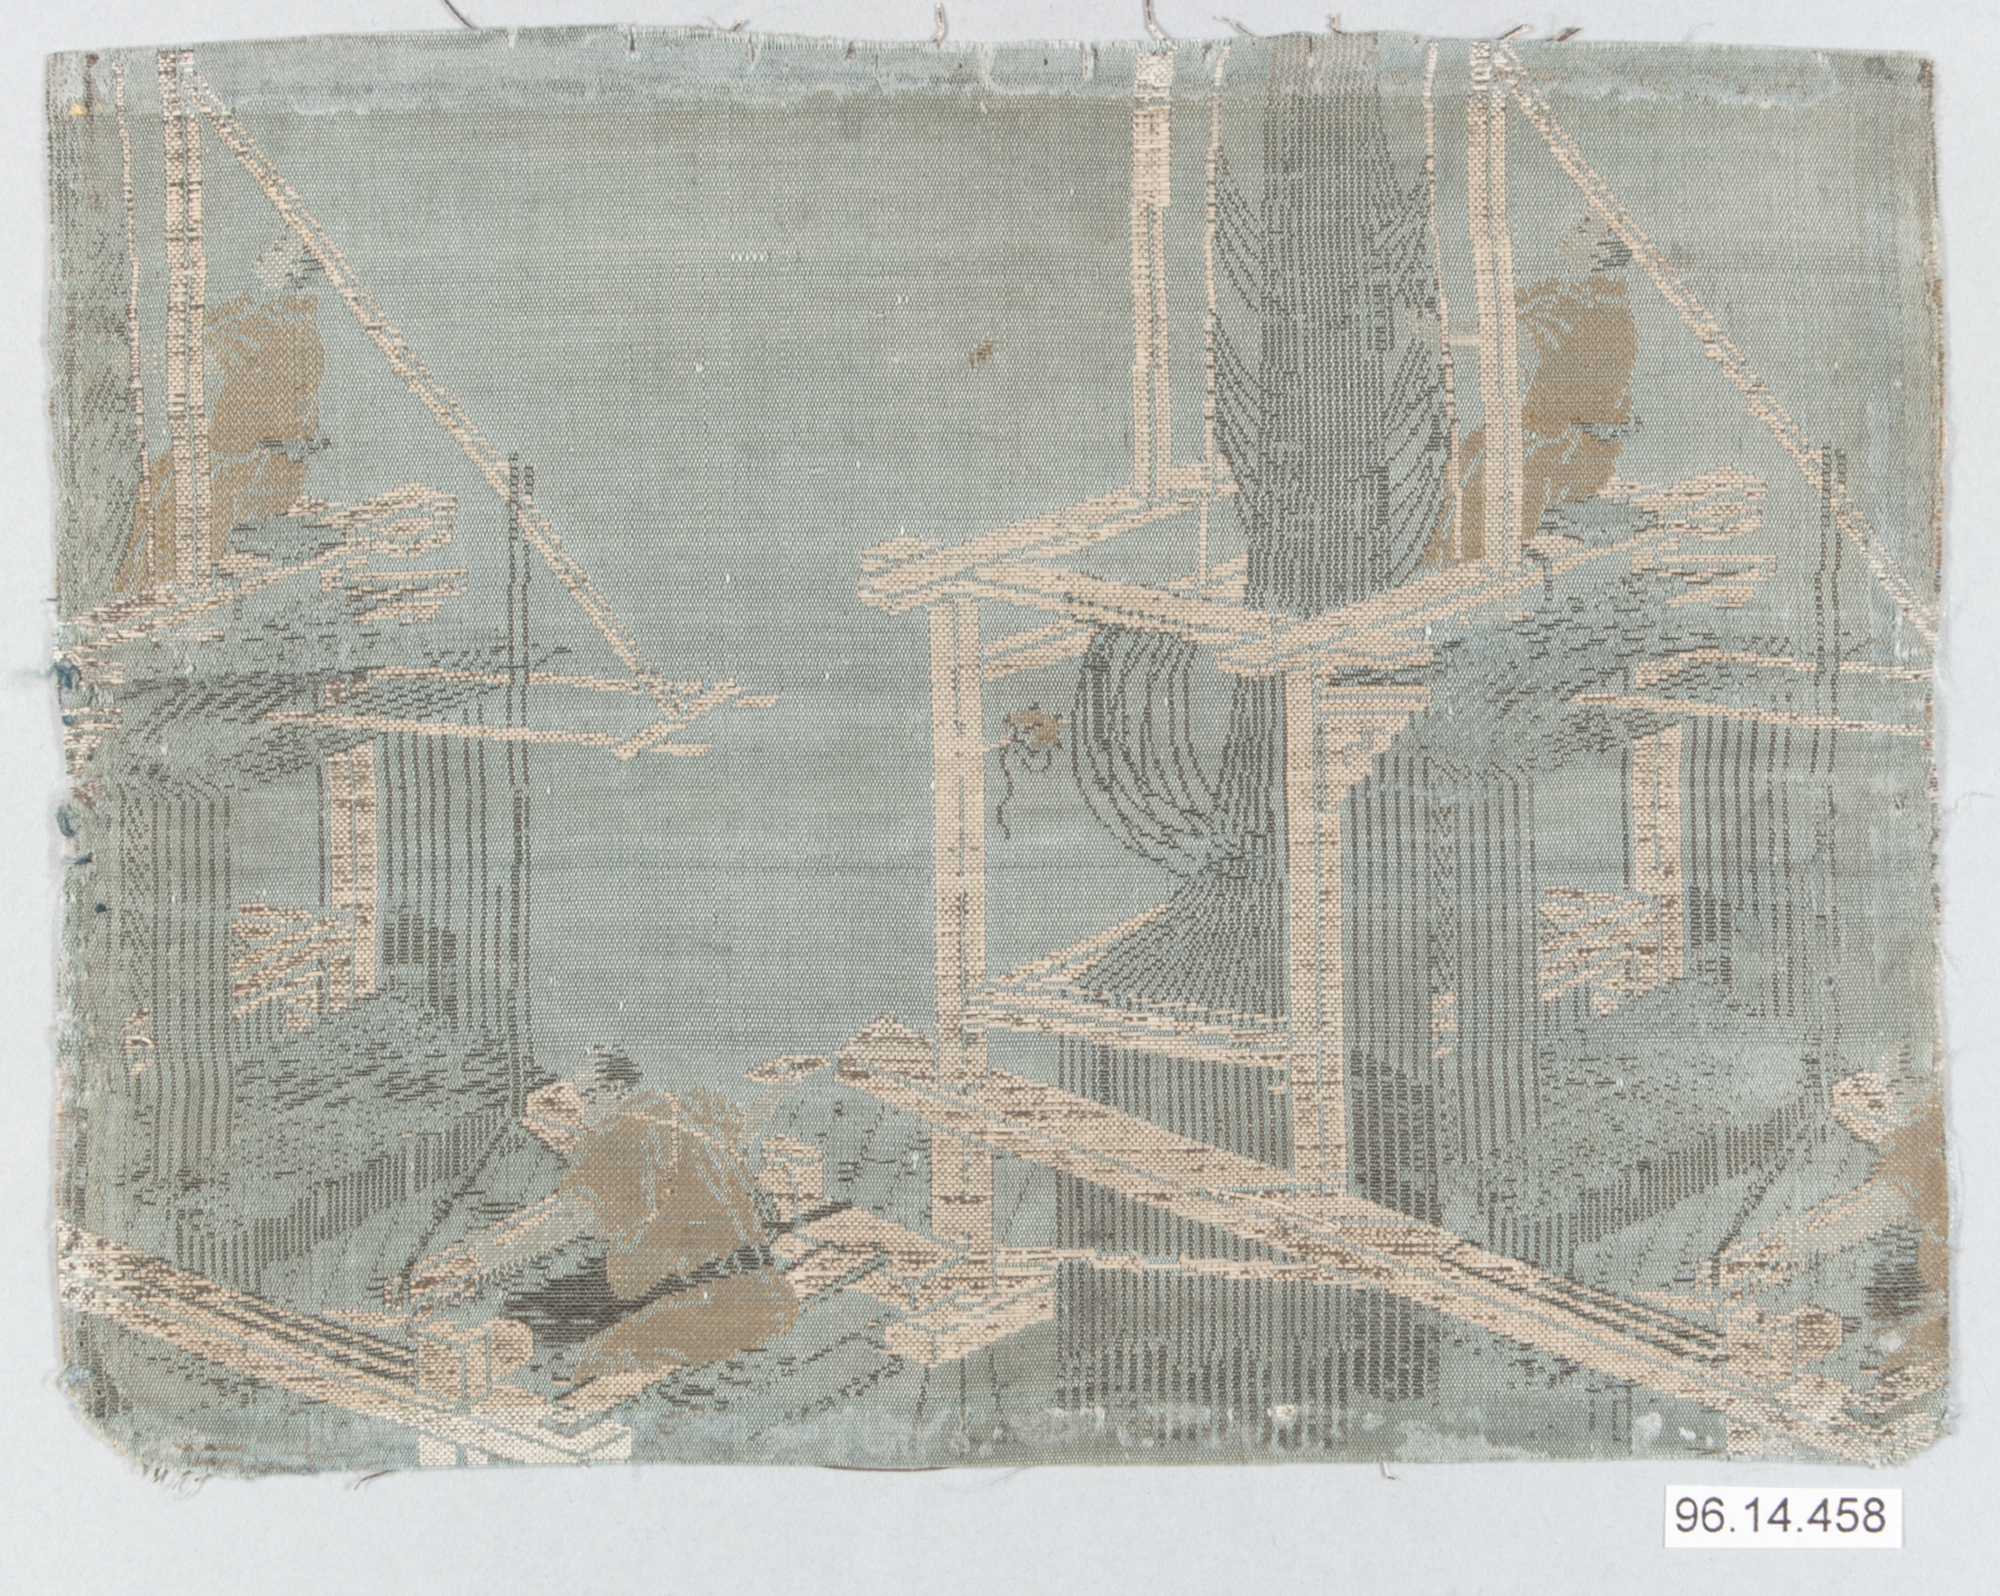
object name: piece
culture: japanese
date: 1701-1900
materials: metal thread, silk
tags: men,working,looms